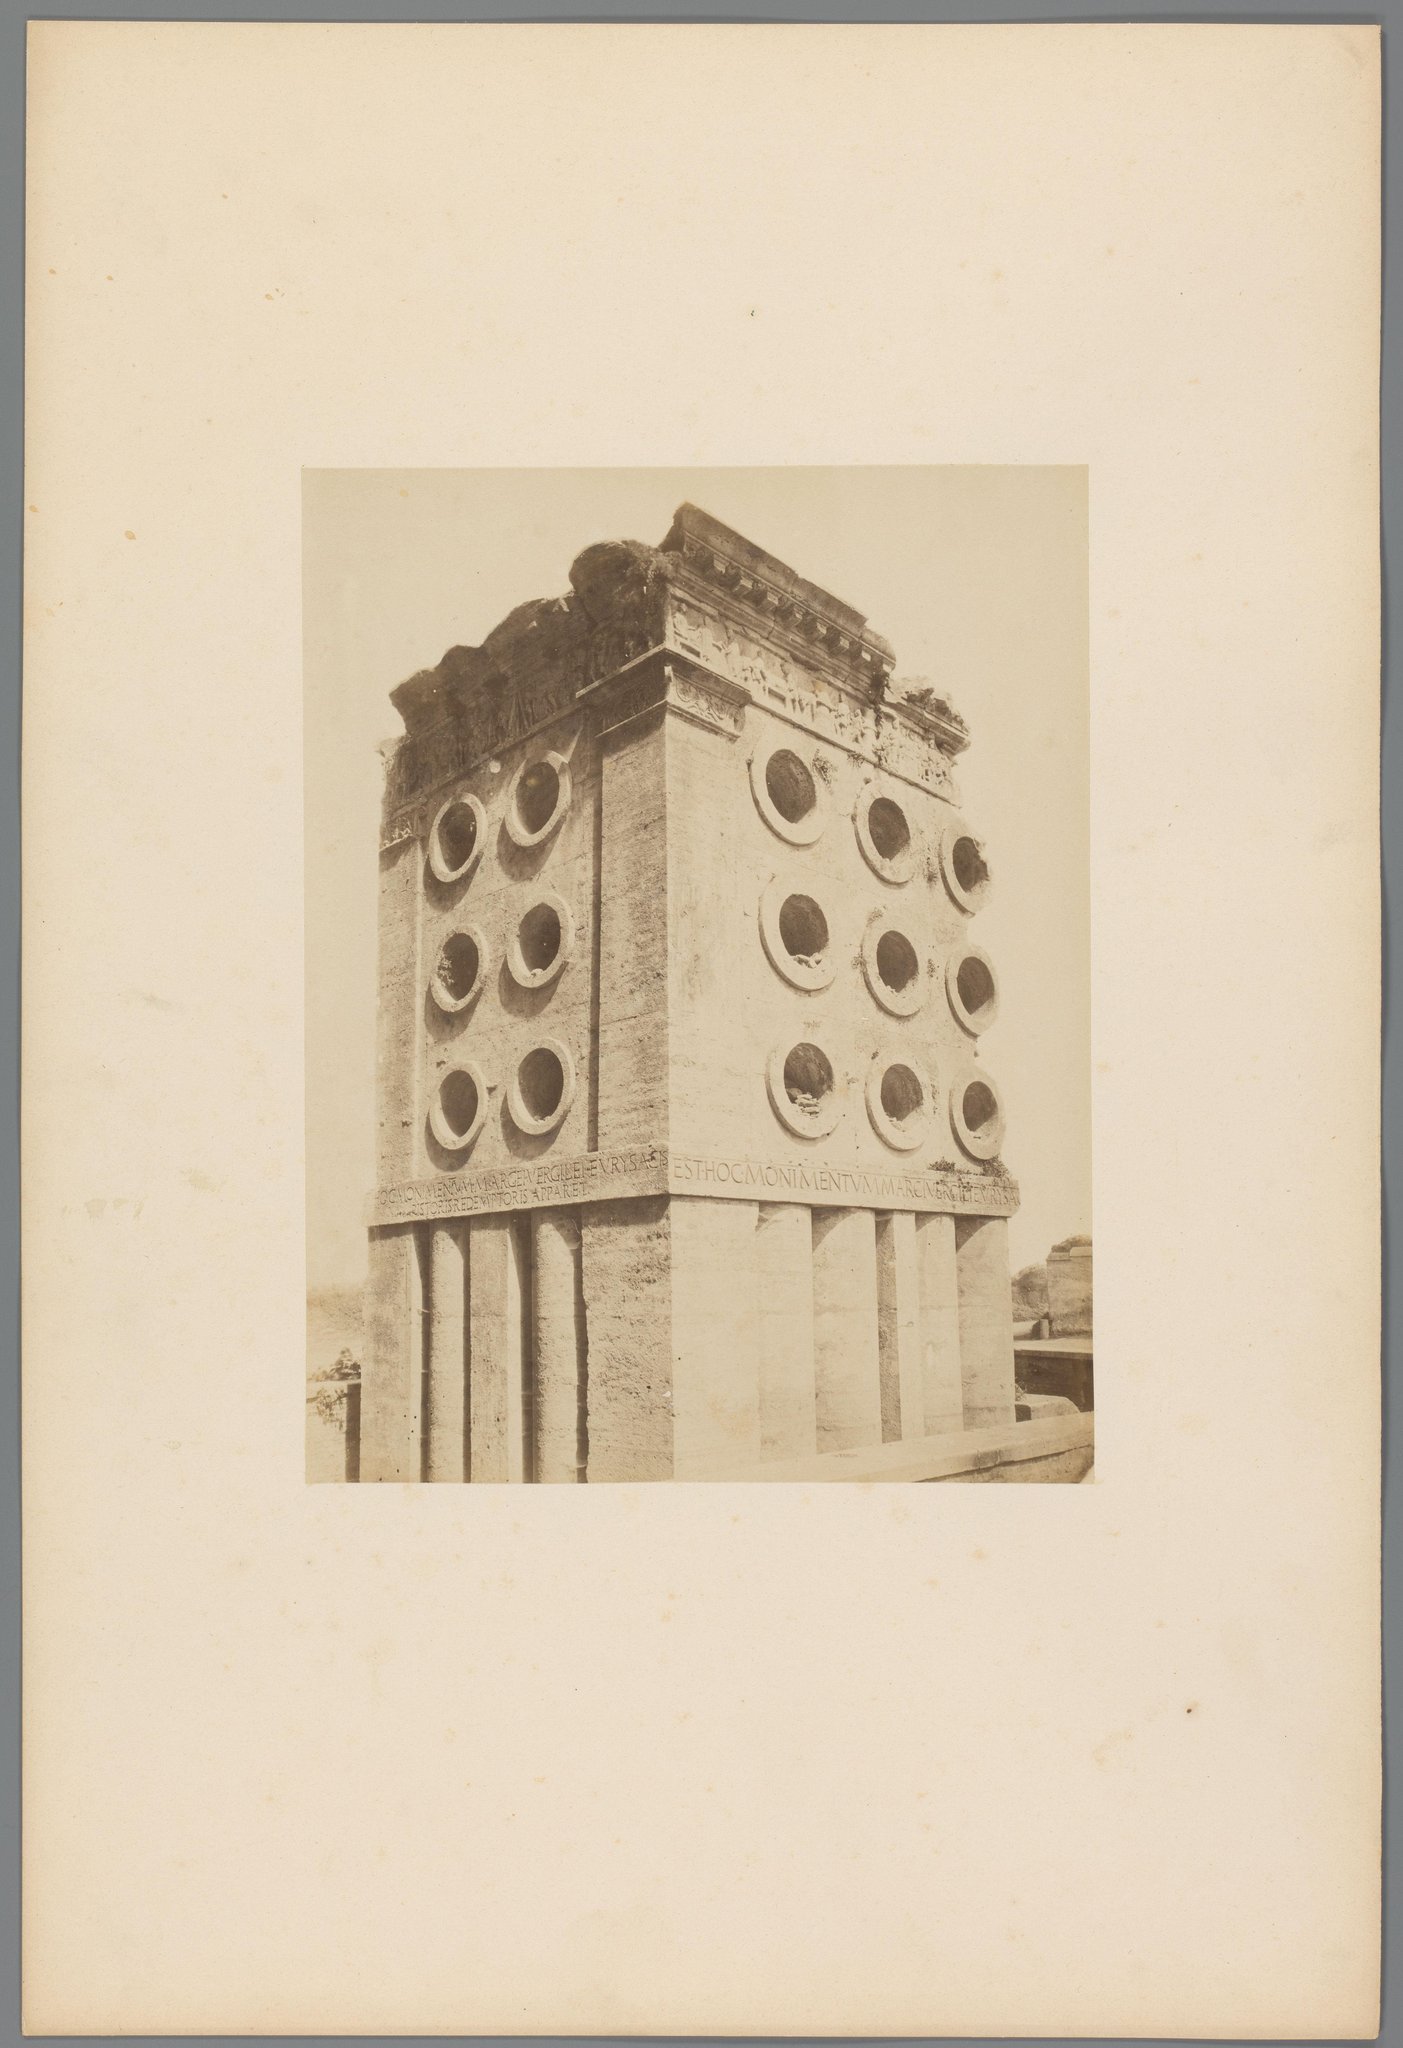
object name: photograph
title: Restanten van de tombe van Eurysaces te Rome, Italië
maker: Anonymous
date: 1851-1900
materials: cardboard, paper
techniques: albumen print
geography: rome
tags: ruin of a building ~ architecture, grave-building, monumental tomb